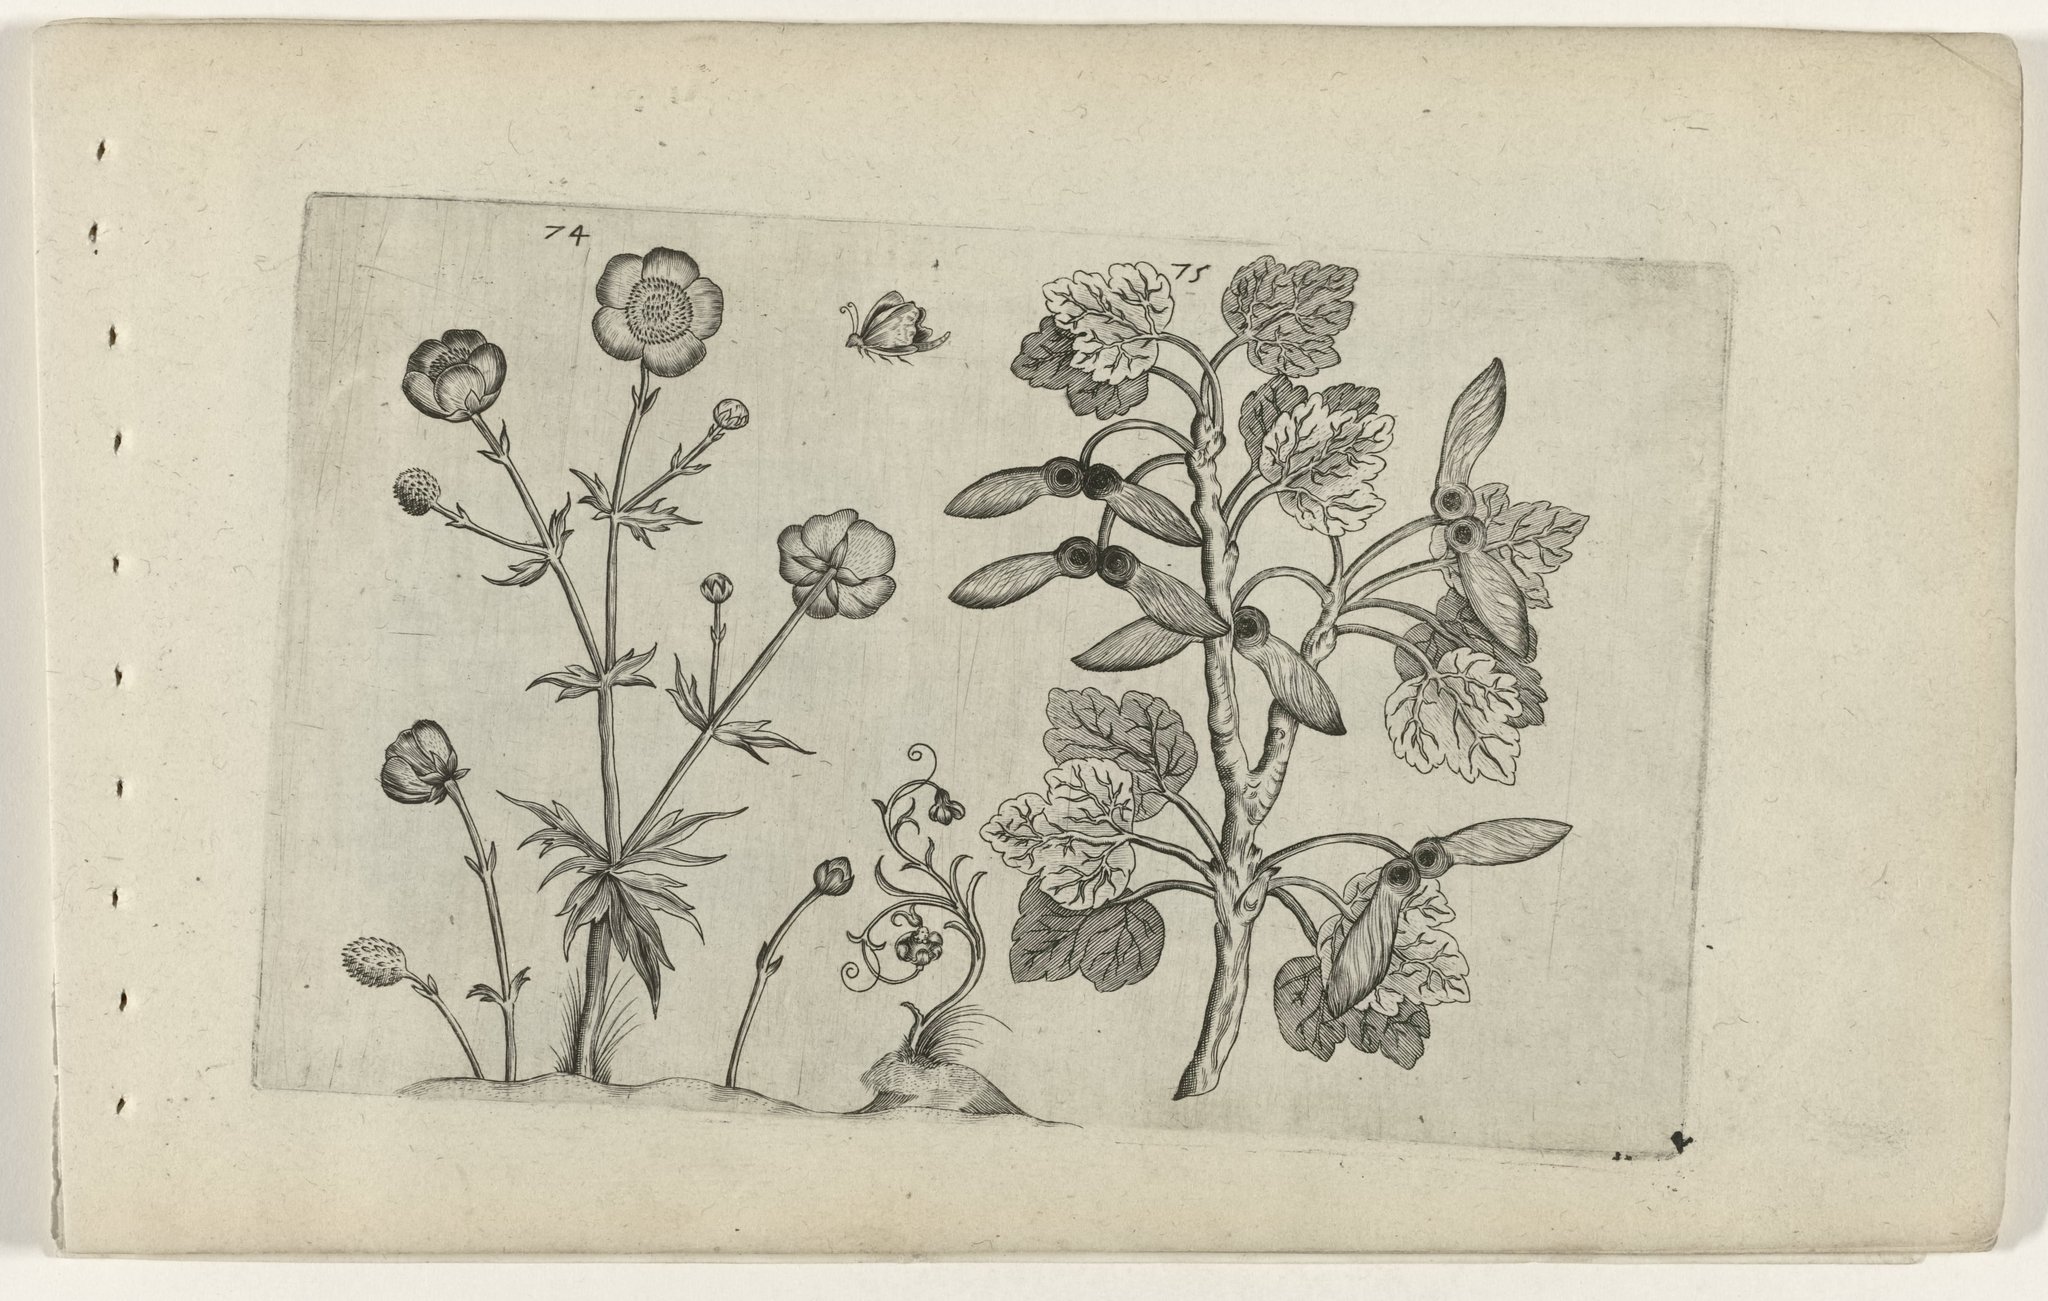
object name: album leaf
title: Cognoscite lilia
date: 1600-1604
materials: paper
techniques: engraving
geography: london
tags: trees: maple (+ parts of plants), flowers: buttercup, botany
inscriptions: collector's mark: Lugt 2228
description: De prenten RP-P-2012-24-1 t/m 61 waren oorspronkelijk als serie samengebonden. De naaigaten op de bladen zijn nog zichtbaar. Het betreft de reeks getiteld: Cognoscite lilia, bestaande uit een titelprent en 60 gravures met 119 genummerde weergaven van planten, bloemen en vruchten, versierd met rinceaux en kleine voorstellingen van dieren. Het gaat om proefdrukken van deze reeks gravures, voor de opschriften en, deels, voor de nummering. Op enkele prenten zijn de nummers met de hand aangebracht. Op de titelprent ontbreekt nog het adres van Crispijn de Passe en Hans Woutneel. De titel is hoogstwaarschijnlijk gegraveerd door Matthias Quad. Deze werkte voor De Passe in Keulen tot 1604. De reeks moet in dit jaar of daarvoor tot stand zijn gebracht. In ieder geval voor 1608, aangezien de uitgever Hans Woutneel in of voor dat jaar overleed. In ieder geval voor 1608, aangezien de uitgever Hans Woutneel in of voor dat jaar overleed. De gravures worden door Ilja Veldman en Anthony Griffiths beschouwd als eigenhandig werk van Crispijn de Passe I. Een van de prenten uit de reeks ontbreekt (nr 21-22) en is vervangen door een ingekleurde afdruk uit een latere uitgave (RP-P-2012-24-61), die onder de titel Altera Pars is opgenomen in de Hortus Floridus, uitgegeven door Crispijn de Passe I en die verder bestaat uit platen van Crispijn de Passe II. De prenten afkomstig uit deze uitgave zijn op de verso voorzien van tekst in boekdruk. De vervangende prent maakte geen deel uit van de gebonden serie aangezien dit blad als enige geen naaigaten heeft. Een deel van de planten, bloemen en vruchten in de Cognoscite lilia gaat terug of is gebaseerd op een reeks aquarellen van Jacques LeMoyne uit circa 1580 en uit 1585, nu in het Victoria and Albert Museum en de British Museum (zie P. Hulton, Jacques LeMoyne, Londen 1977, dl 1, p. 156-162 en p. 165-173).